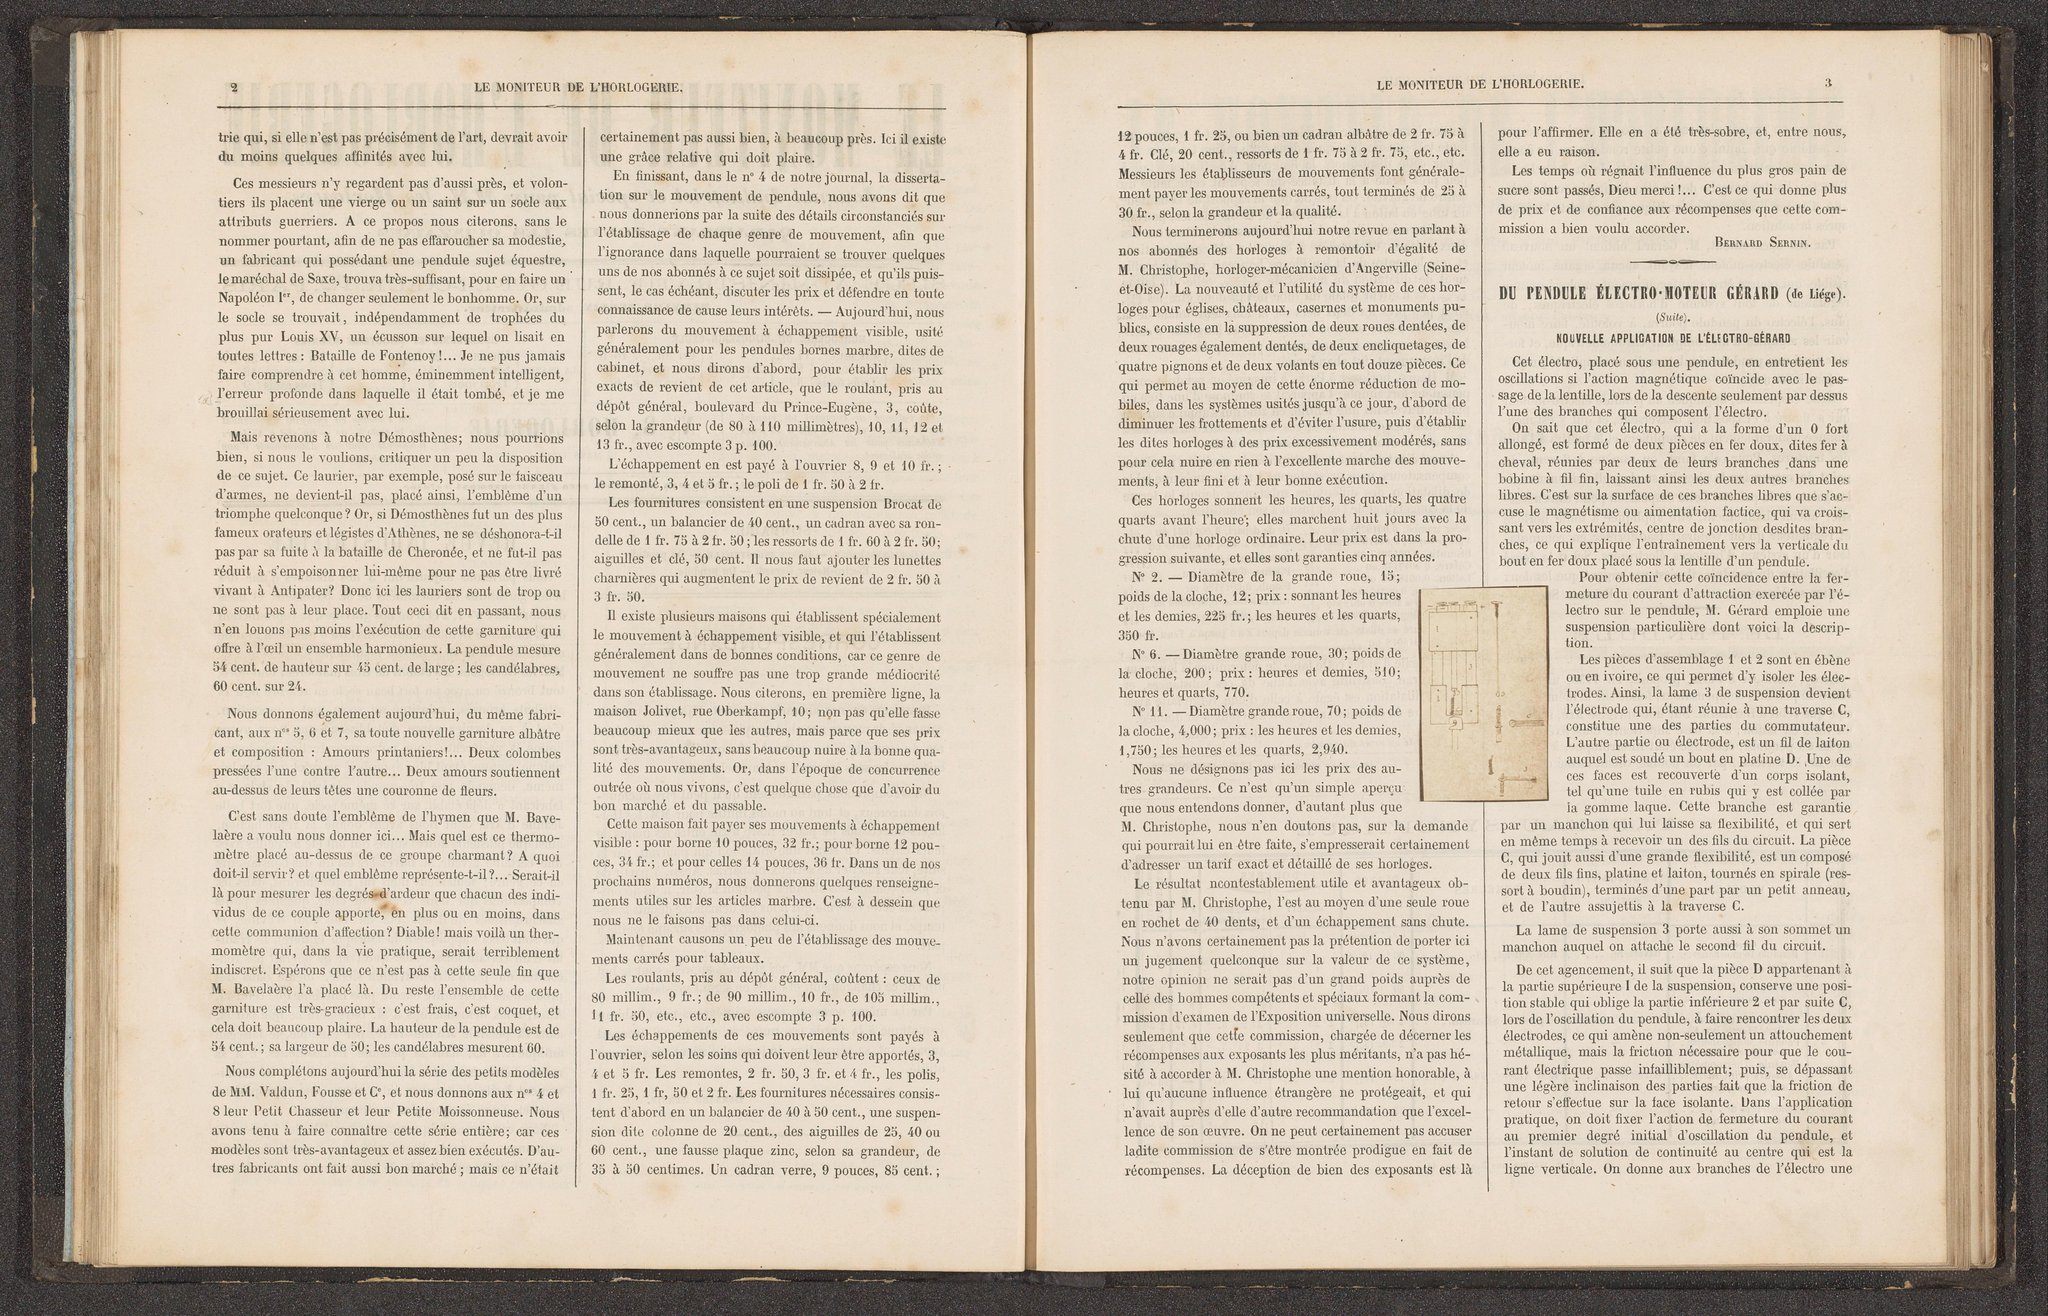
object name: page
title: Technische tekening van een onderdeel van een elektrische pendule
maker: Anonymous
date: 1858-1868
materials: photographic support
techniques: albumen print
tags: pendulum (theory)